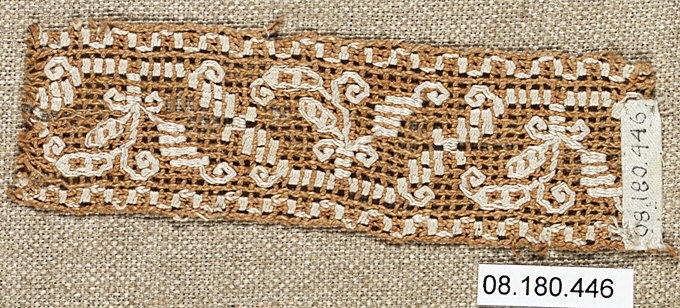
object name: border scrap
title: Scrap of border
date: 1501-1600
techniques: embroidery